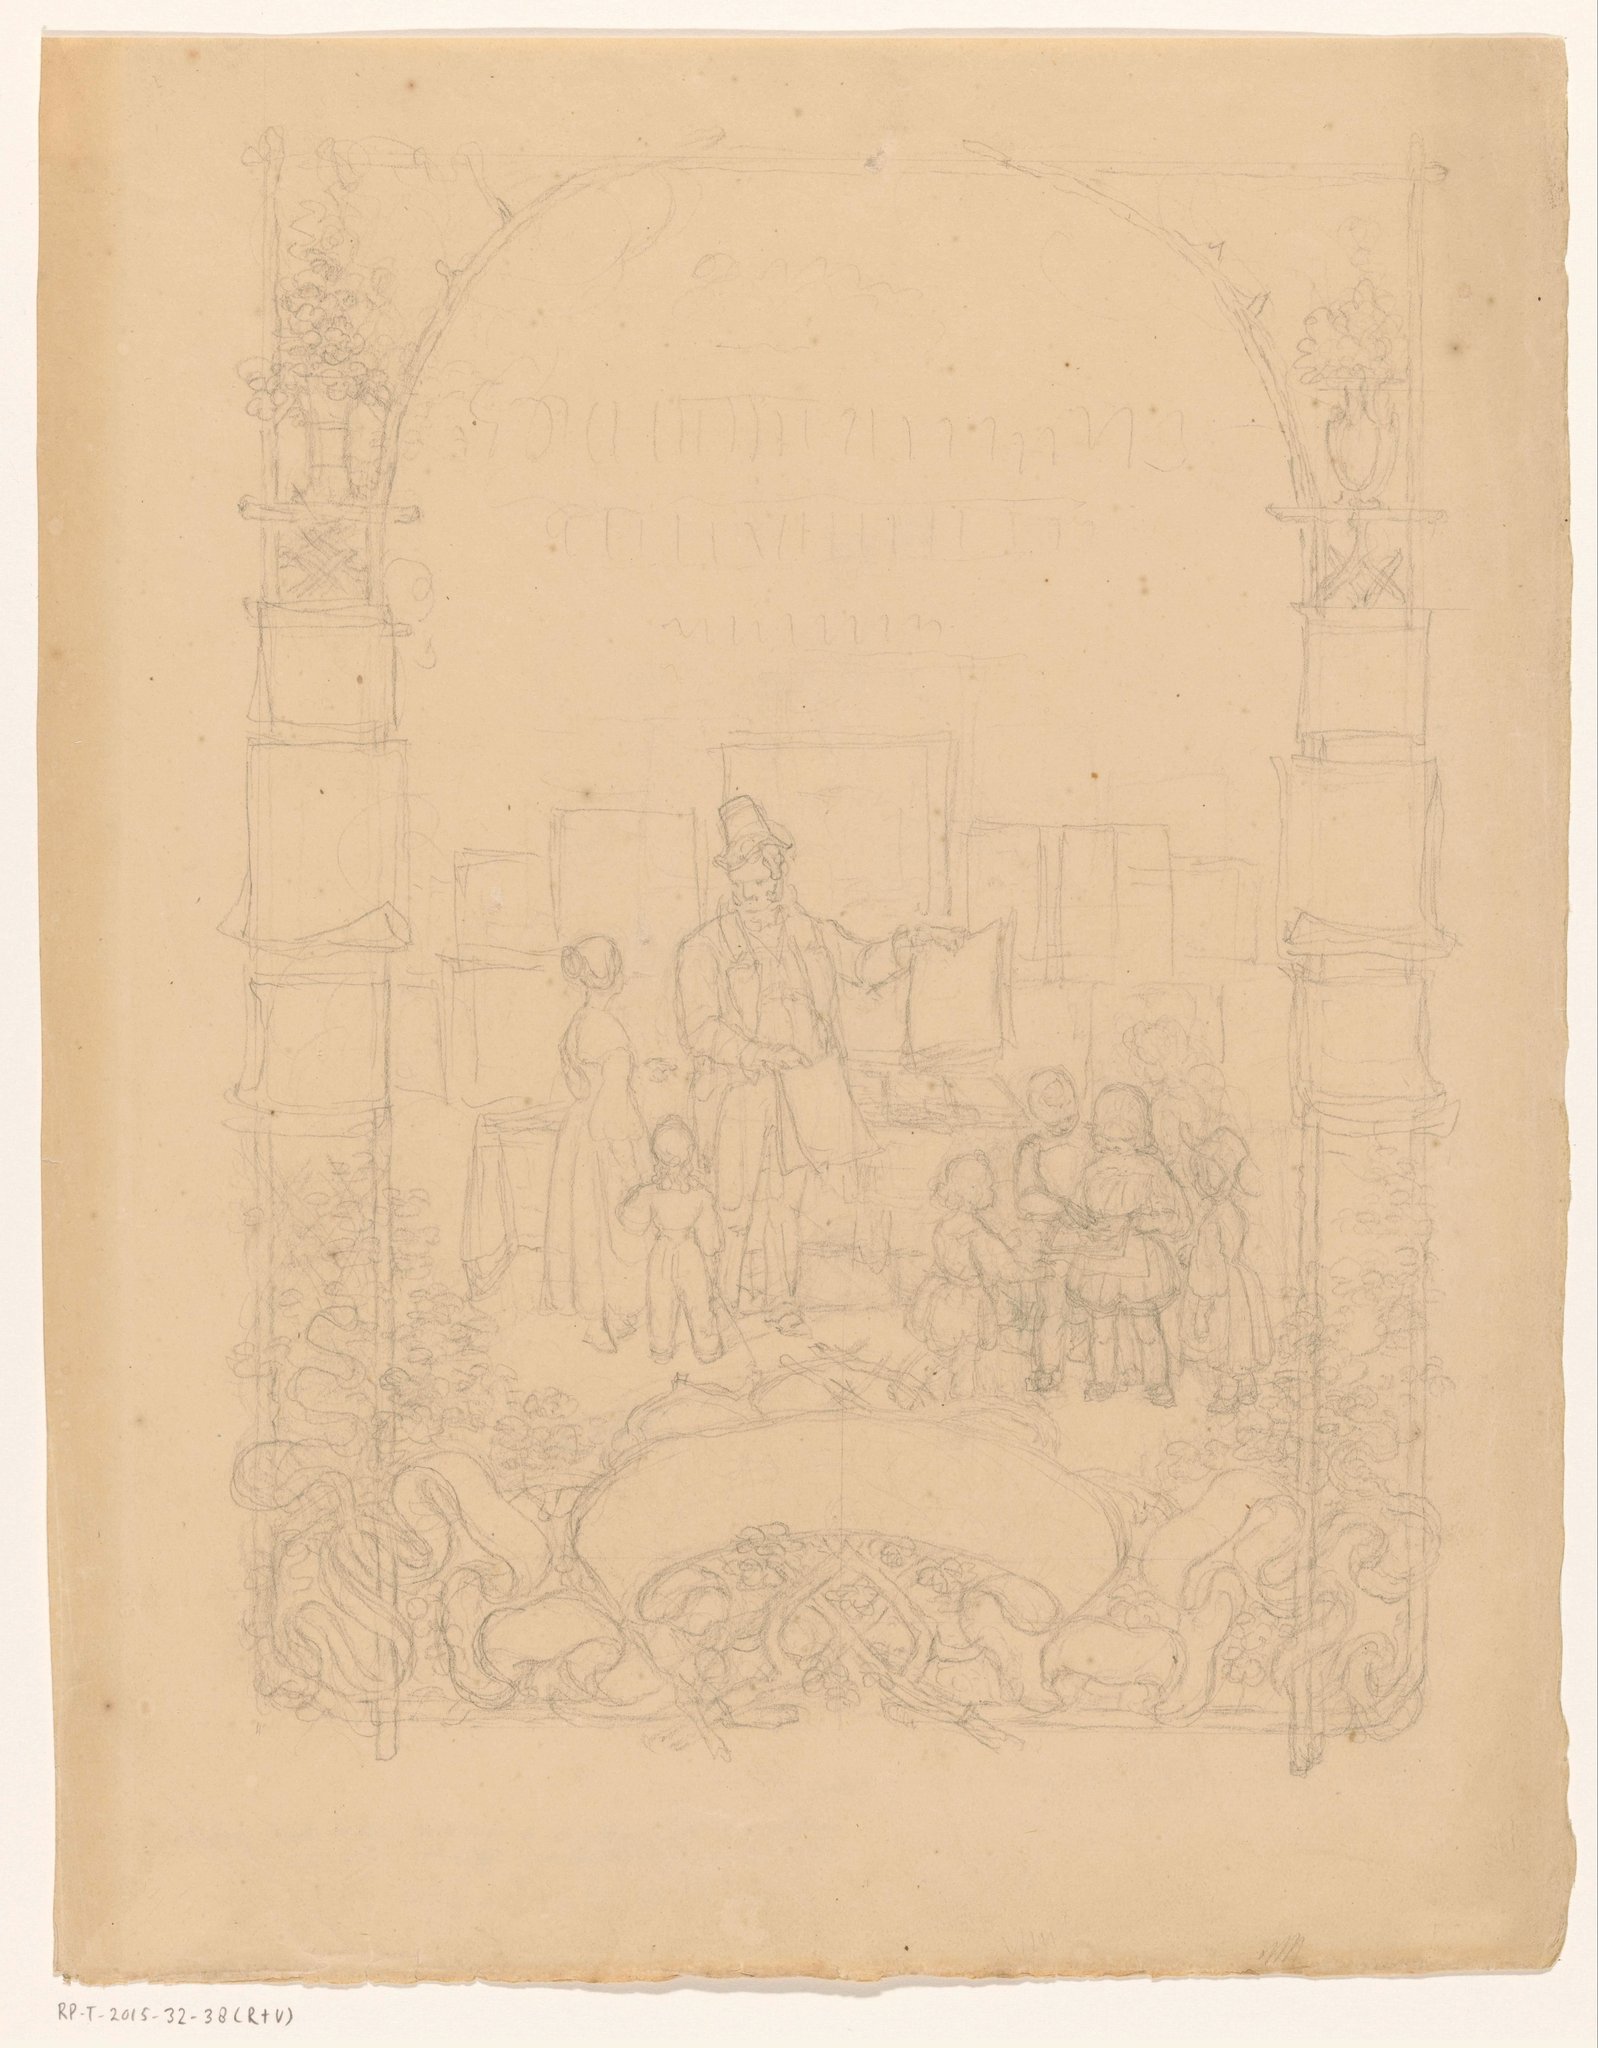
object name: design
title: Prentverkoper in een omlijsting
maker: august ferdinand hopfgarten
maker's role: draughtsman, painter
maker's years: 1807-1896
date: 1817-1896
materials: paper, pencil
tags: print, e.g.: engraving, etching, lithograph, street-trader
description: Een prentverkoper staat voor zijn kraam met in beide handen een prent. Zes kinderen kijken toe, waarvan een aan de hand van zijn moeder. In een omlijsting bestaande uit bloemen en prenten met onderin een banderol.